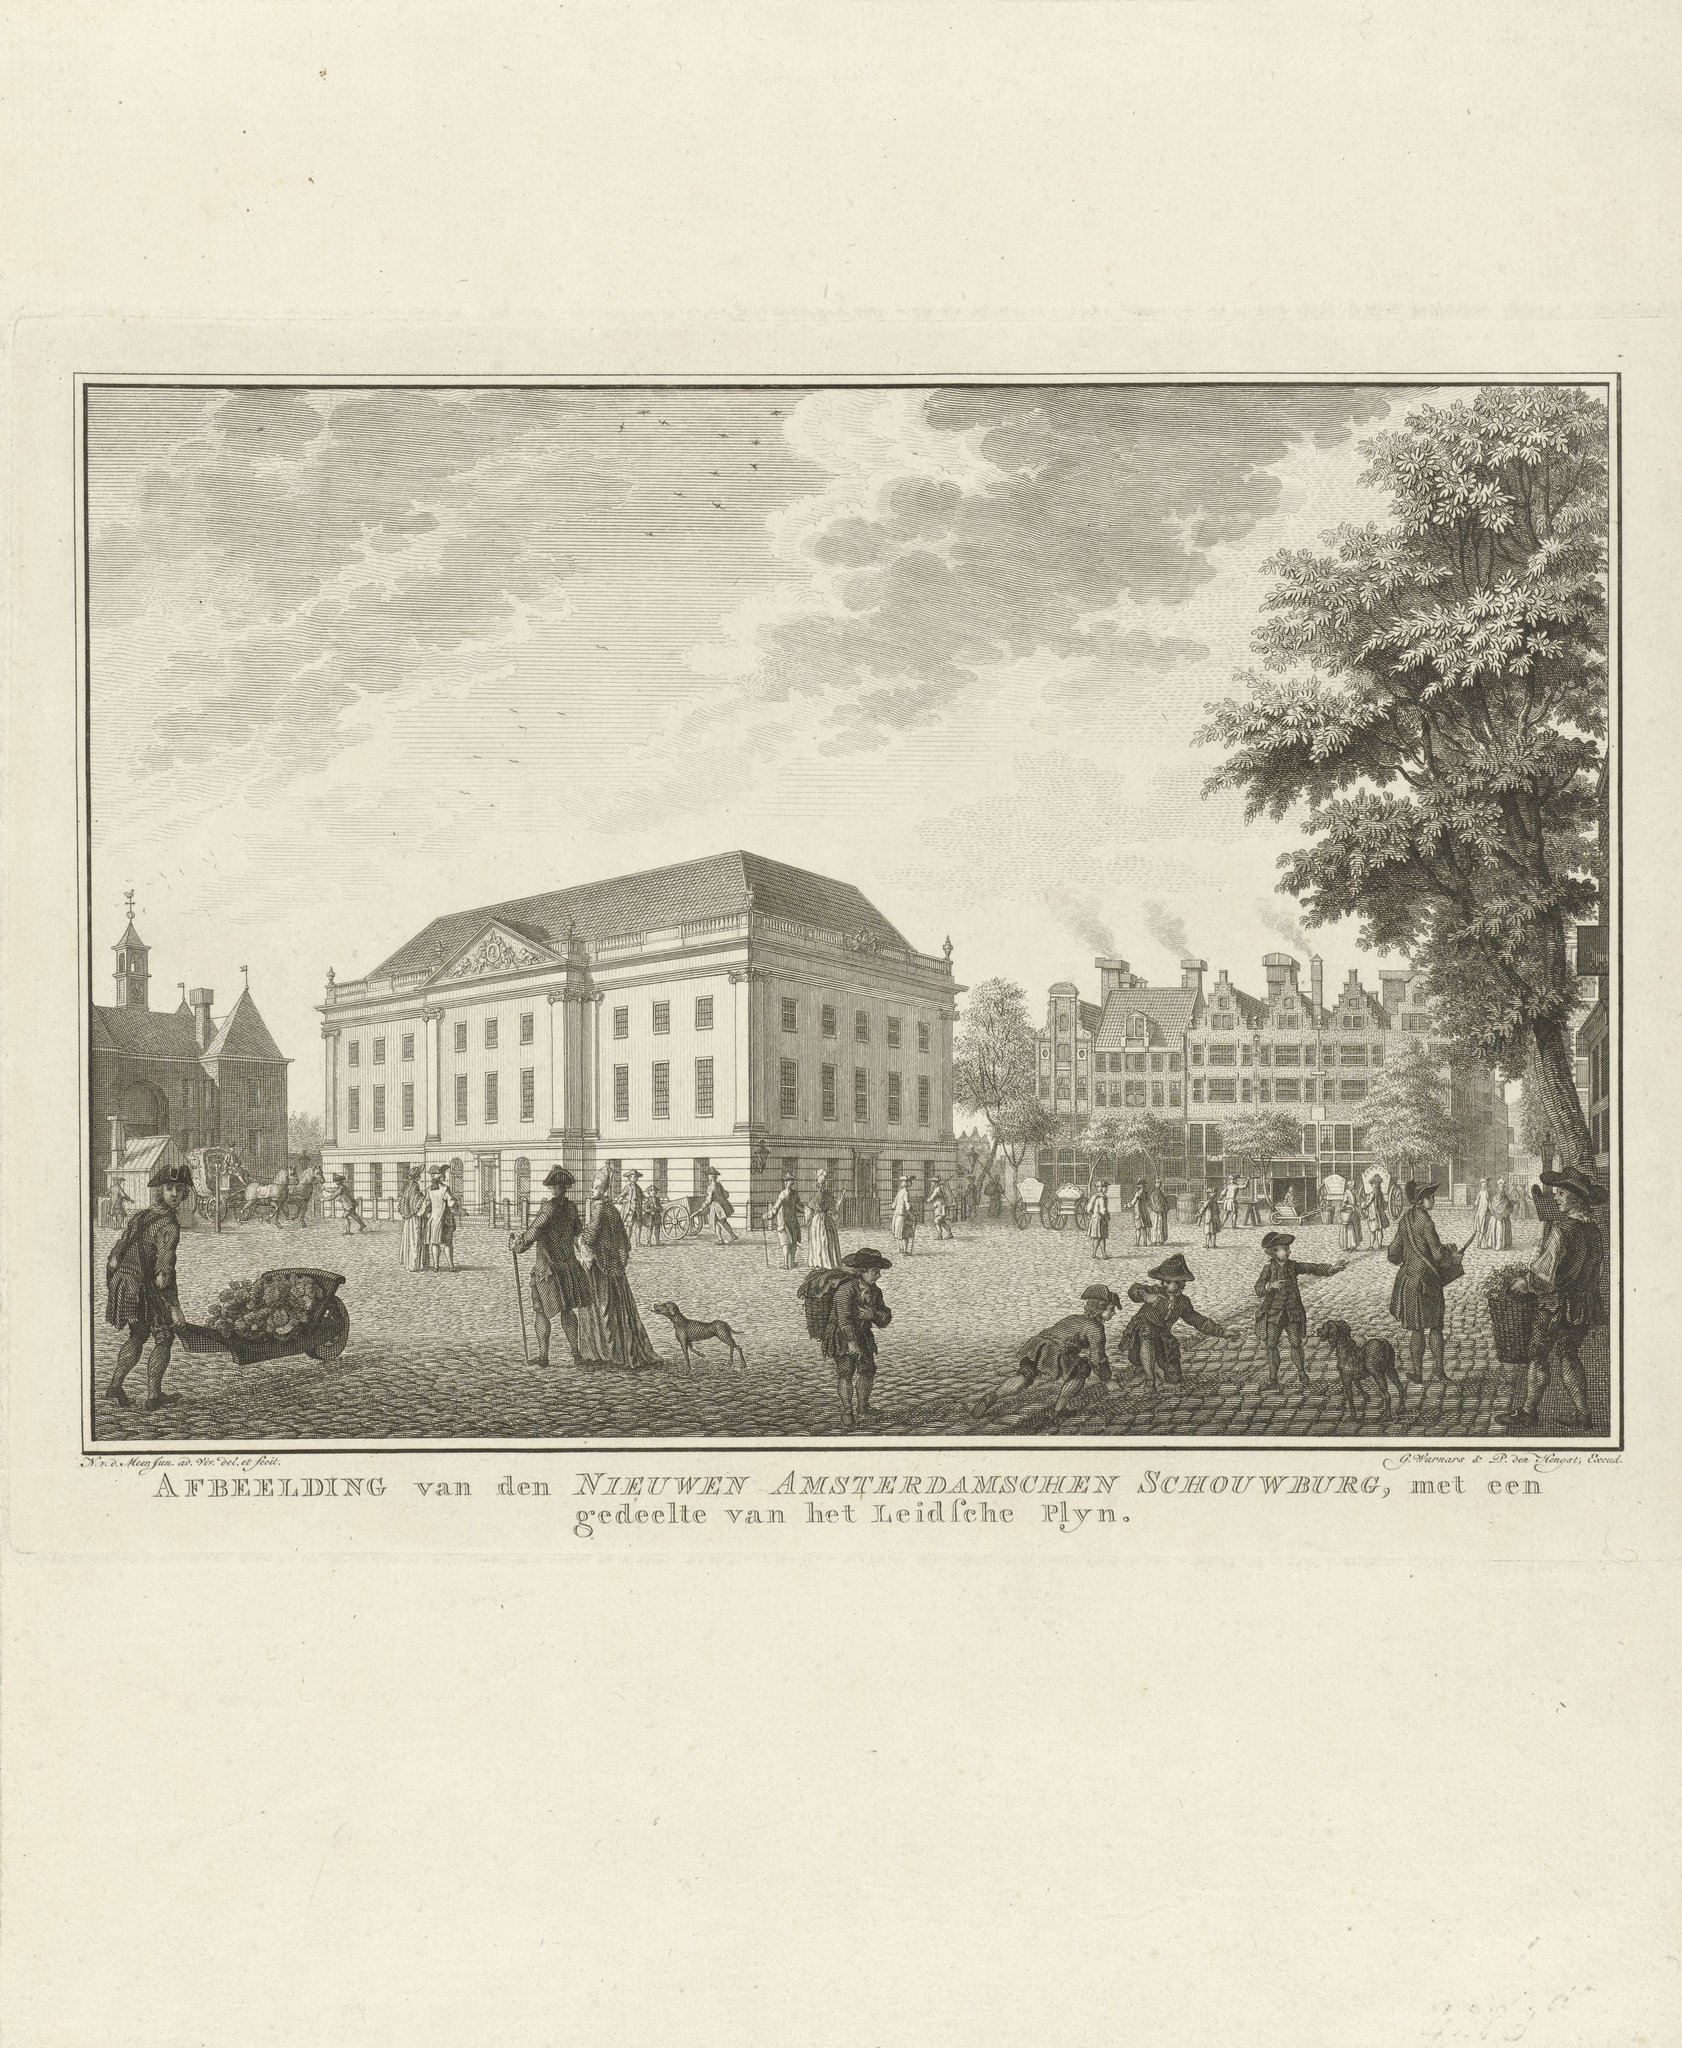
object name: book illustration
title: Afbeelding van den Nieuwen Amsterdamschen Schouwburg, met een gedeelte van het Leidsche Plyn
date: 1774-1775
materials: paper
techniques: engraving, etching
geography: amsterdam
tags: theatre (building), city-gate, square, place, circus, etc. (+ city(-scape) with figures, staffage)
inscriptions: collector's mark: Lugt 2228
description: Gezicht op de op 15 september 1774 ingewijde Amsterdamse Schouwburg op het Leidseplein. Links op de achtergrond de Leidsepoort. Deze stadsschouwburg werd gebouwd om de in 1772 afgebrande schouwburg aan de Keizersgracht te vervangen en brandde in 1890 zelf af.